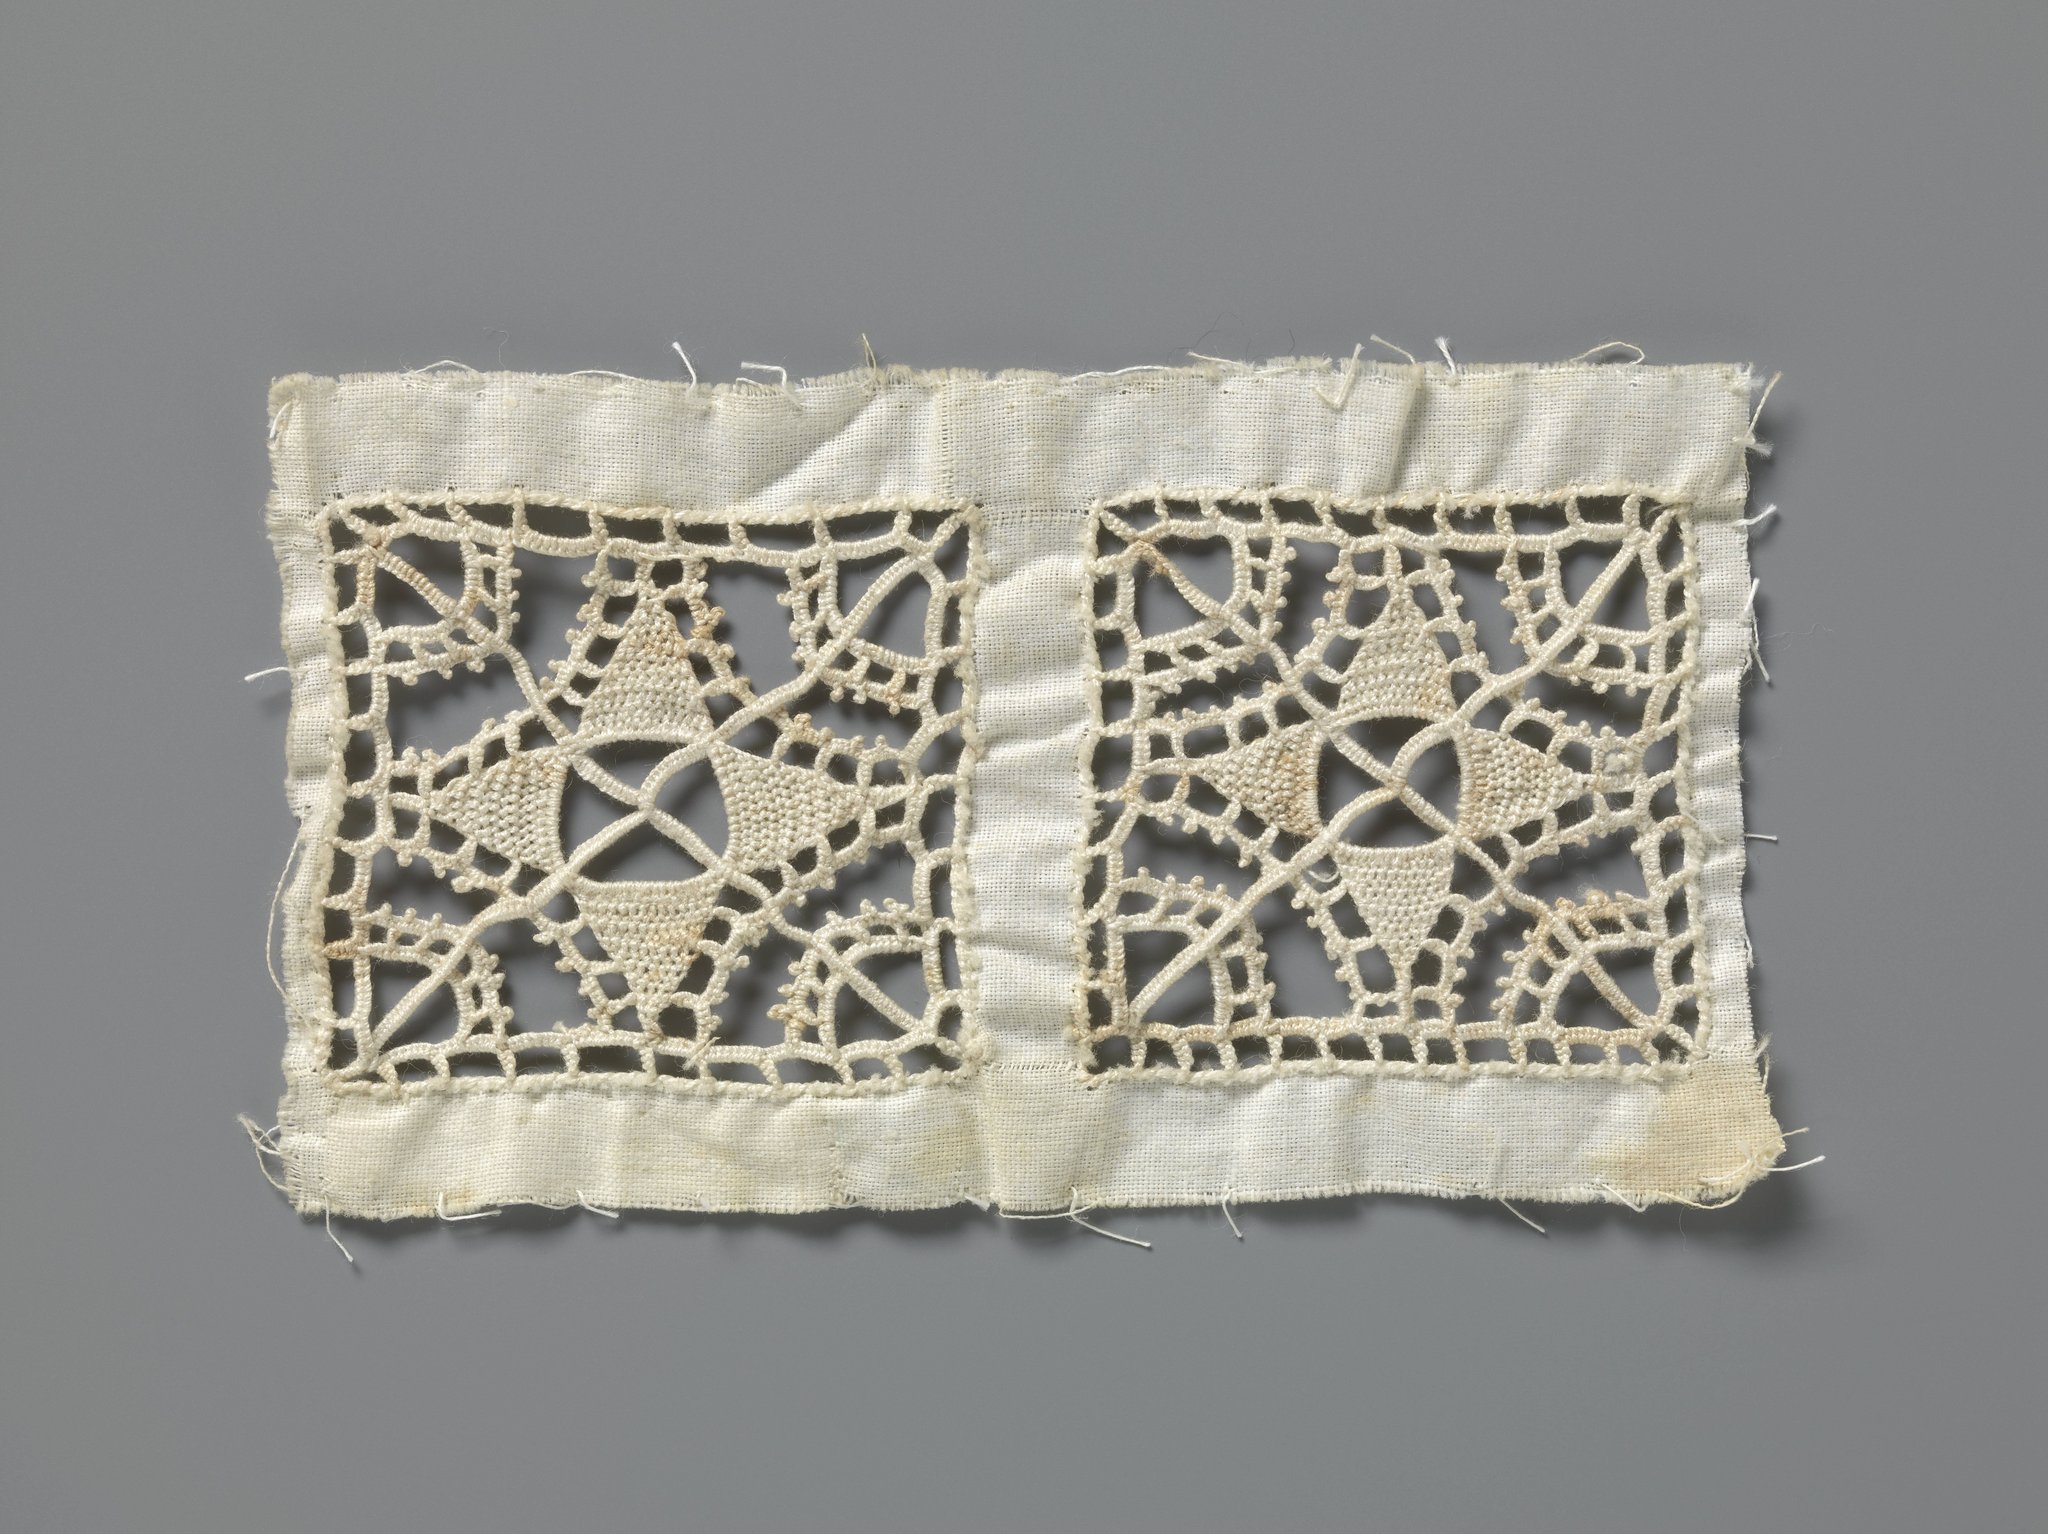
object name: sample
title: Staal naaldkant met twee opengewerkte vierkanten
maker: Anonymous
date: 1800-1824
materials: linen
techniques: ivory point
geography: apennijnen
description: Ivoorkant is een zeer sterke Italiaanse geknoopte naaldkant met korrelige structuur (granité-karakter), gemaakt met de Arabische of puncetto-festonknoopsteek. Teruggaand op een eeuwenoude techniek, wordt deze kant gemaakt op de vingers, zonder perkament. De draad is grof, dikwijls in zijde. Geometrische patronen met boogvormige zelfkanten. Scherp afgelijnde en dichtgewerkte motieven. Wegens zijn bleke kleur en zijn wasachtige glans gelijkend op gesneden ivoor en op oude Venetiaanse kant. De ivoorkant werd gemaakt in de Italiaanse Alpen, in de vallei van Piedmont ten noorden van Genua, aan de voet van de Monte Rosa (in Valsesia) en in de afgelegen landbouwgebieden in Italië. In het begin van de 20e eeuw verliest de ivoorkant zijn voorvaderlijk karakter door toepassing van luchtiger patronen. (bron: Kantlexicon, J. Coene, 2002)